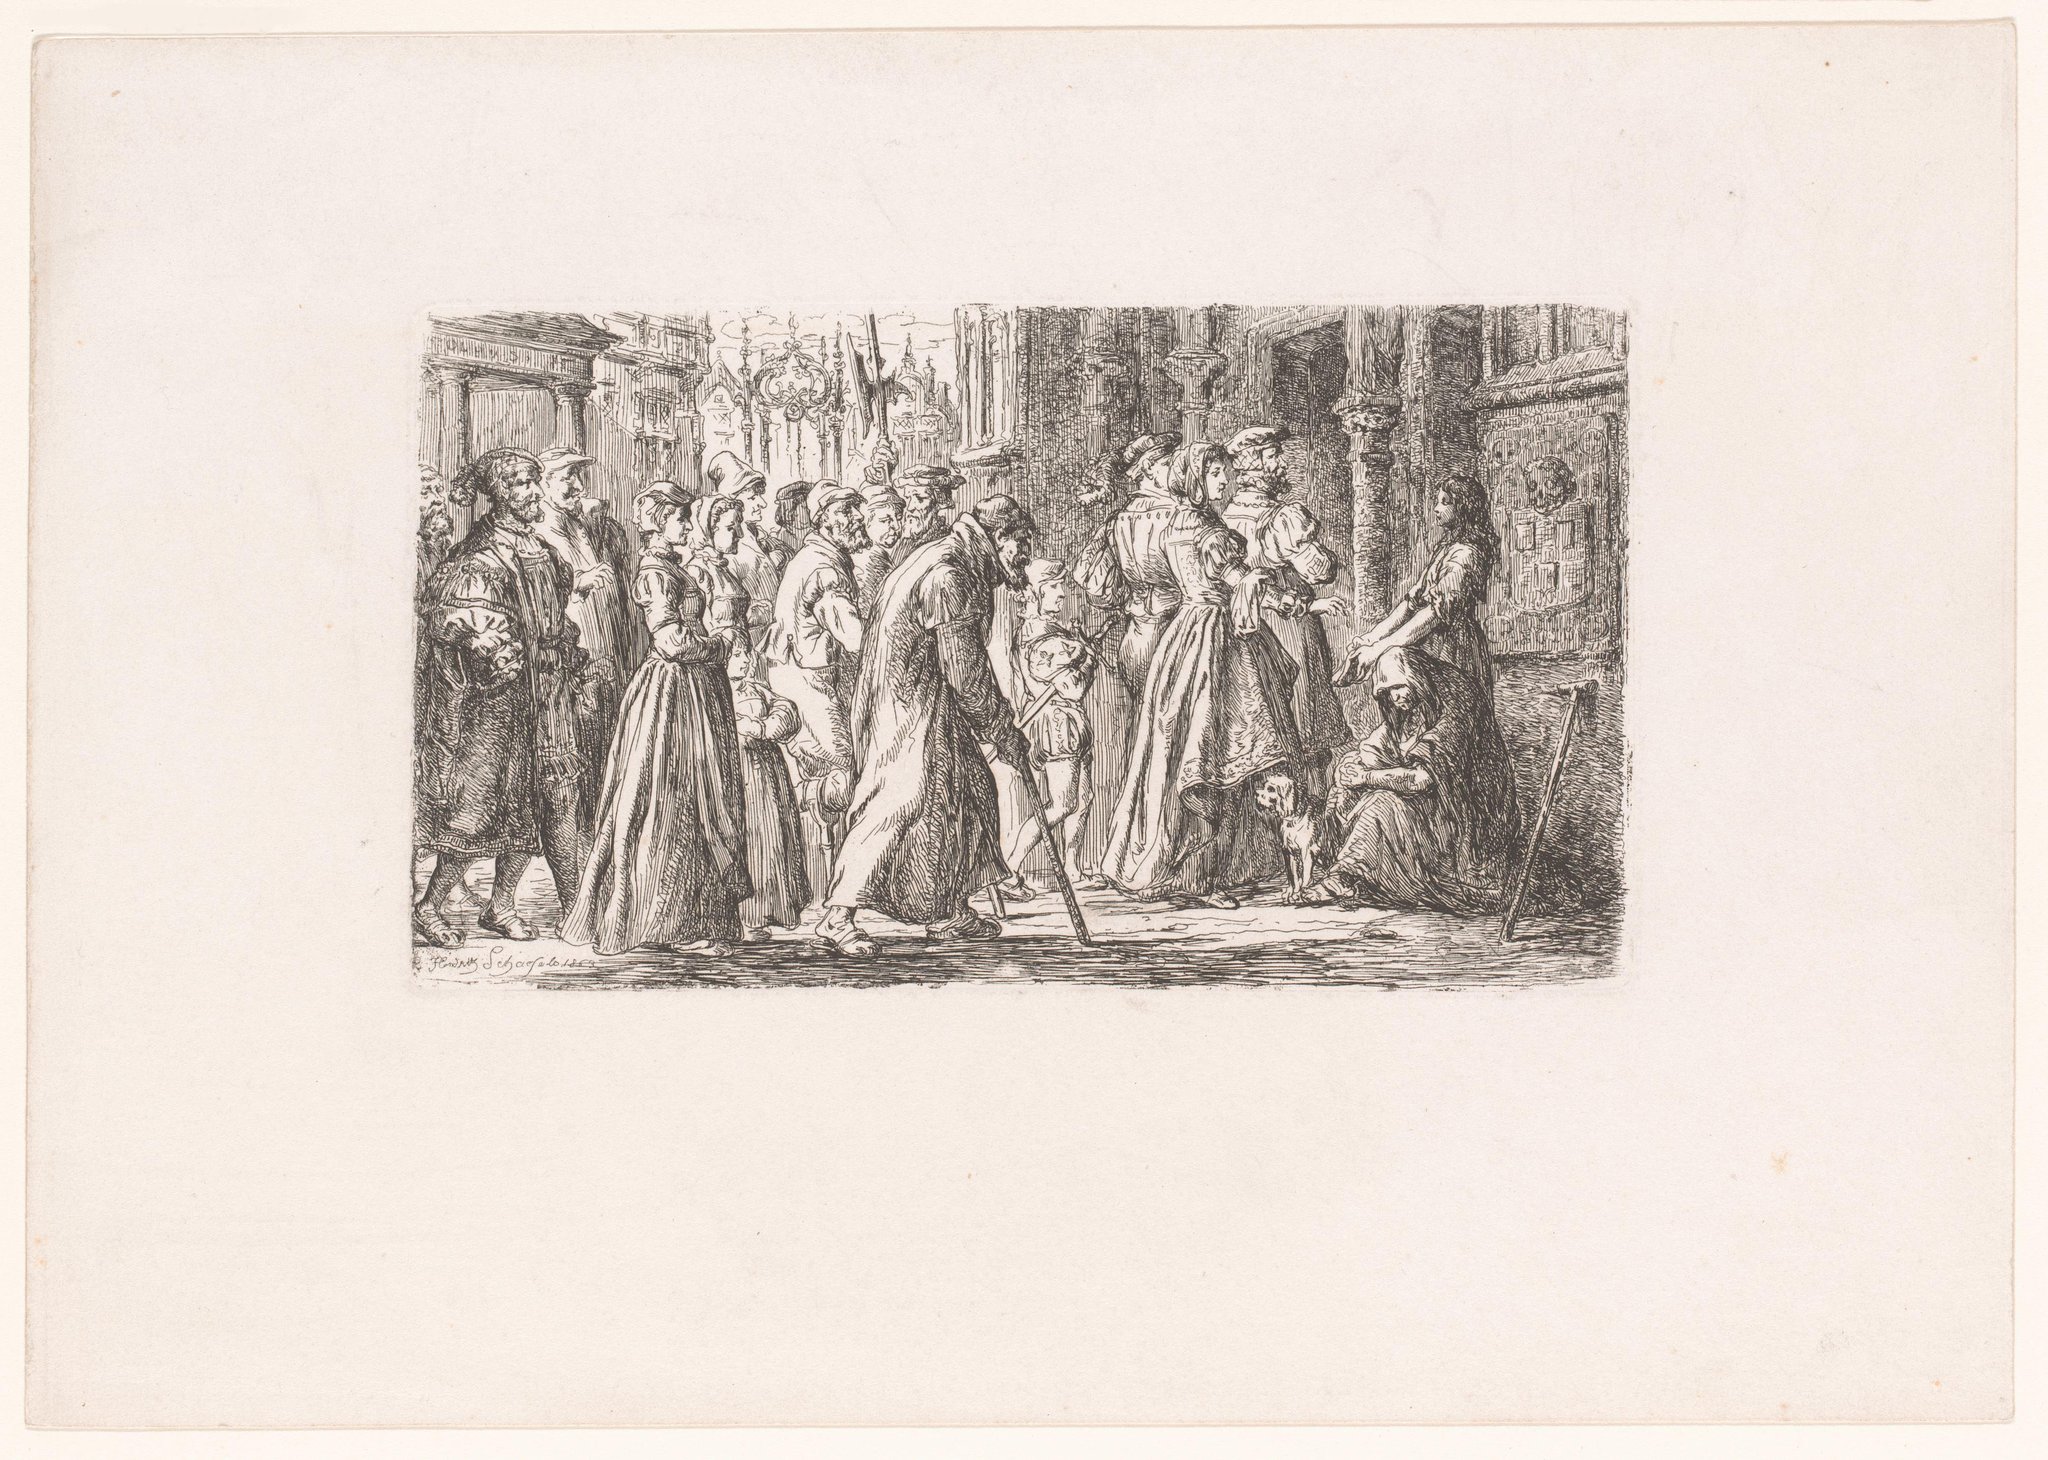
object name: print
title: Groep figuren geeft geld aan bedelaars bij het binnengaan van de kathedraal te Antwerpen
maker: henri françois schaefels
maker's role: print maker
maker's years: 1827-1904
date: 1863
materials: paper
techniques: etching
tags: parts of church exterior and annexes: portal, giving alms or other charity, e.g.: handing out food, going to church, beggar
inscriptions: collector's mark: Lugt 2228